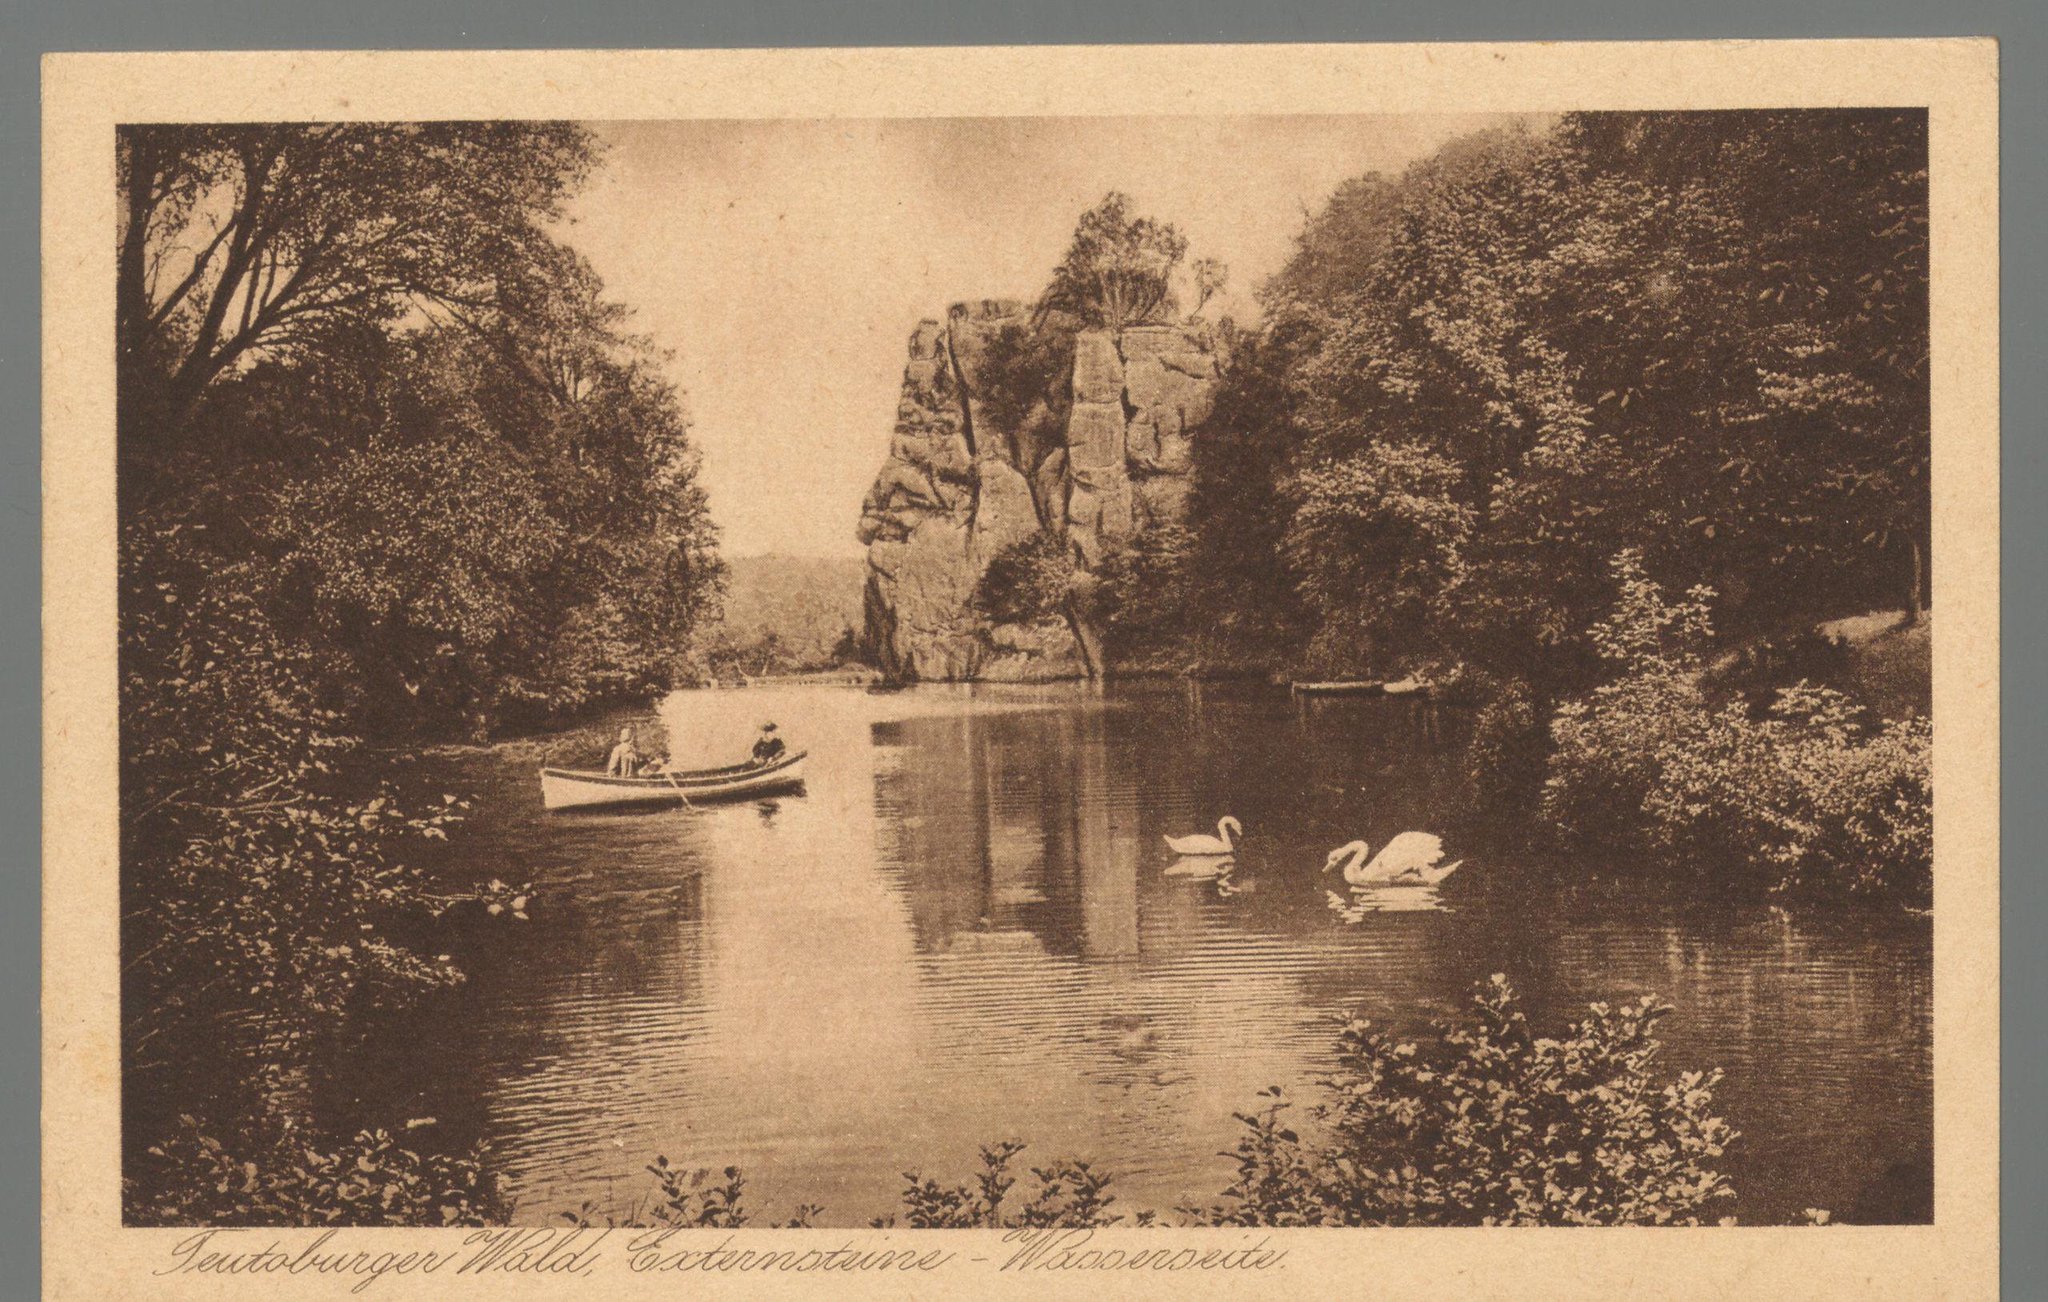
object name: ansichtkaart, prentbriefkaart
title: Teutoburger Wald, Externsteine - Wasserseite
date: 1905-1930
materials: cardboard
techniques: rotogravure, writing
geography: halberstadt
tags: lake, rocks